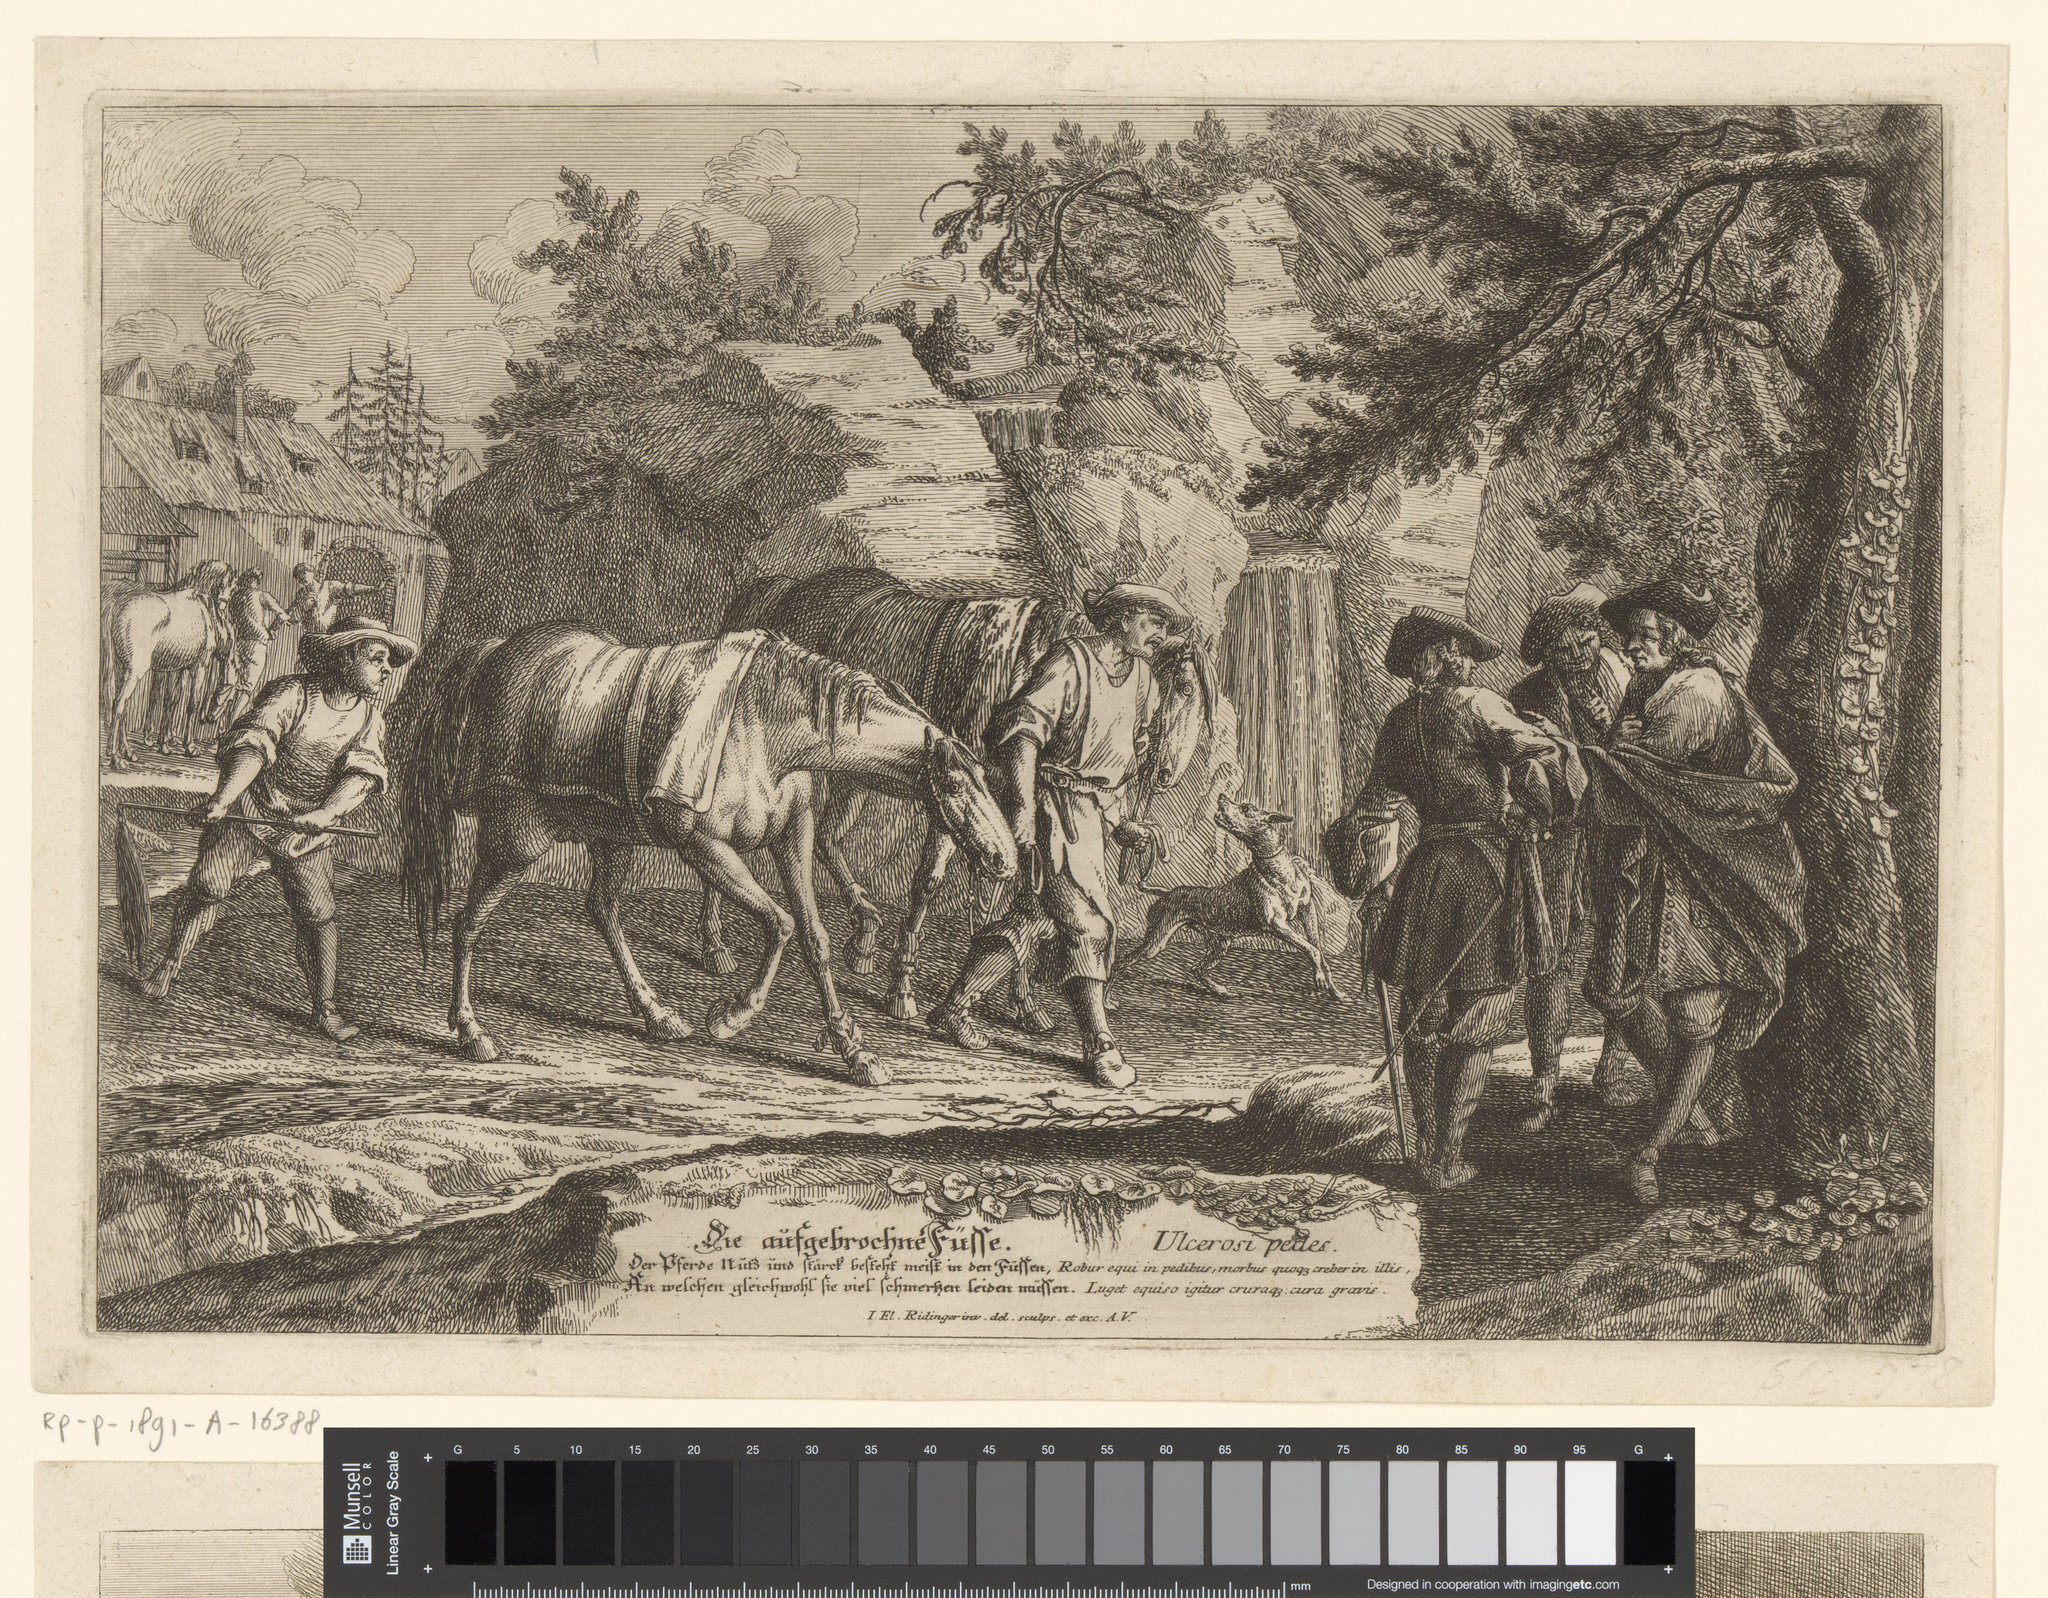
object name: print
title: Paard met een gebroken voet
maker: johann elias ridinger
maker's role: draughtsman, painter, print maker, publisher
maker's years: 1698-1767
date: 1708-1767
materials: paper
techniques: etching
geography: augsburg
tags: veterinarian, horse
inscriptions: collector's mark: Lugt 2228